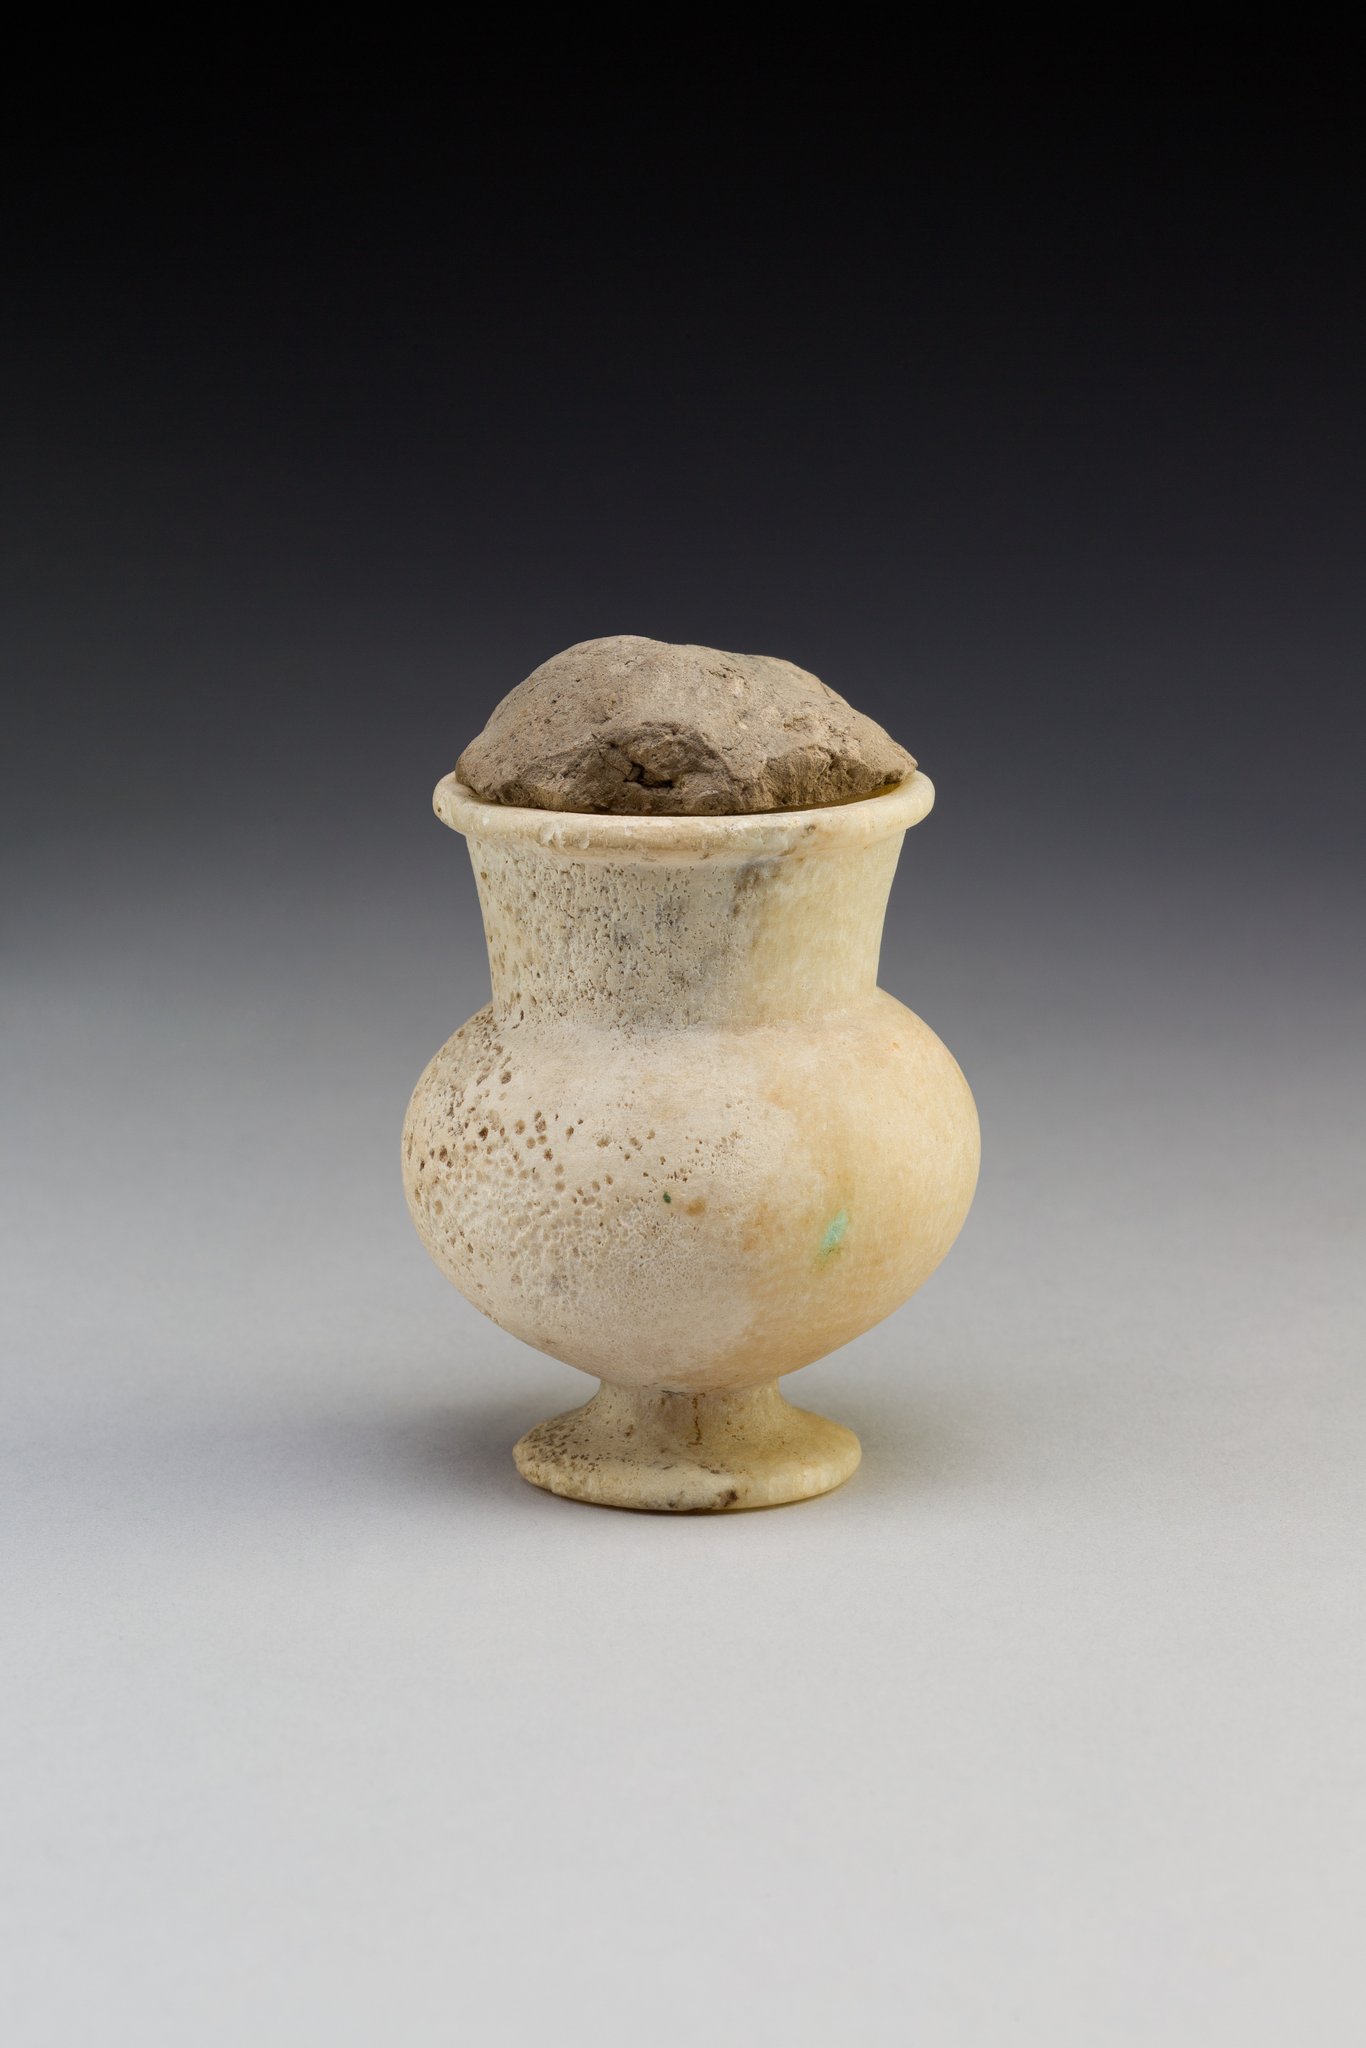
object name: jar, mud stopper, amenemhat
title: Open-Mouthed Cosmetic Jar with Mud Stopper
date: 1504-1447 BCE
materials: mud, stone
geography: egypt